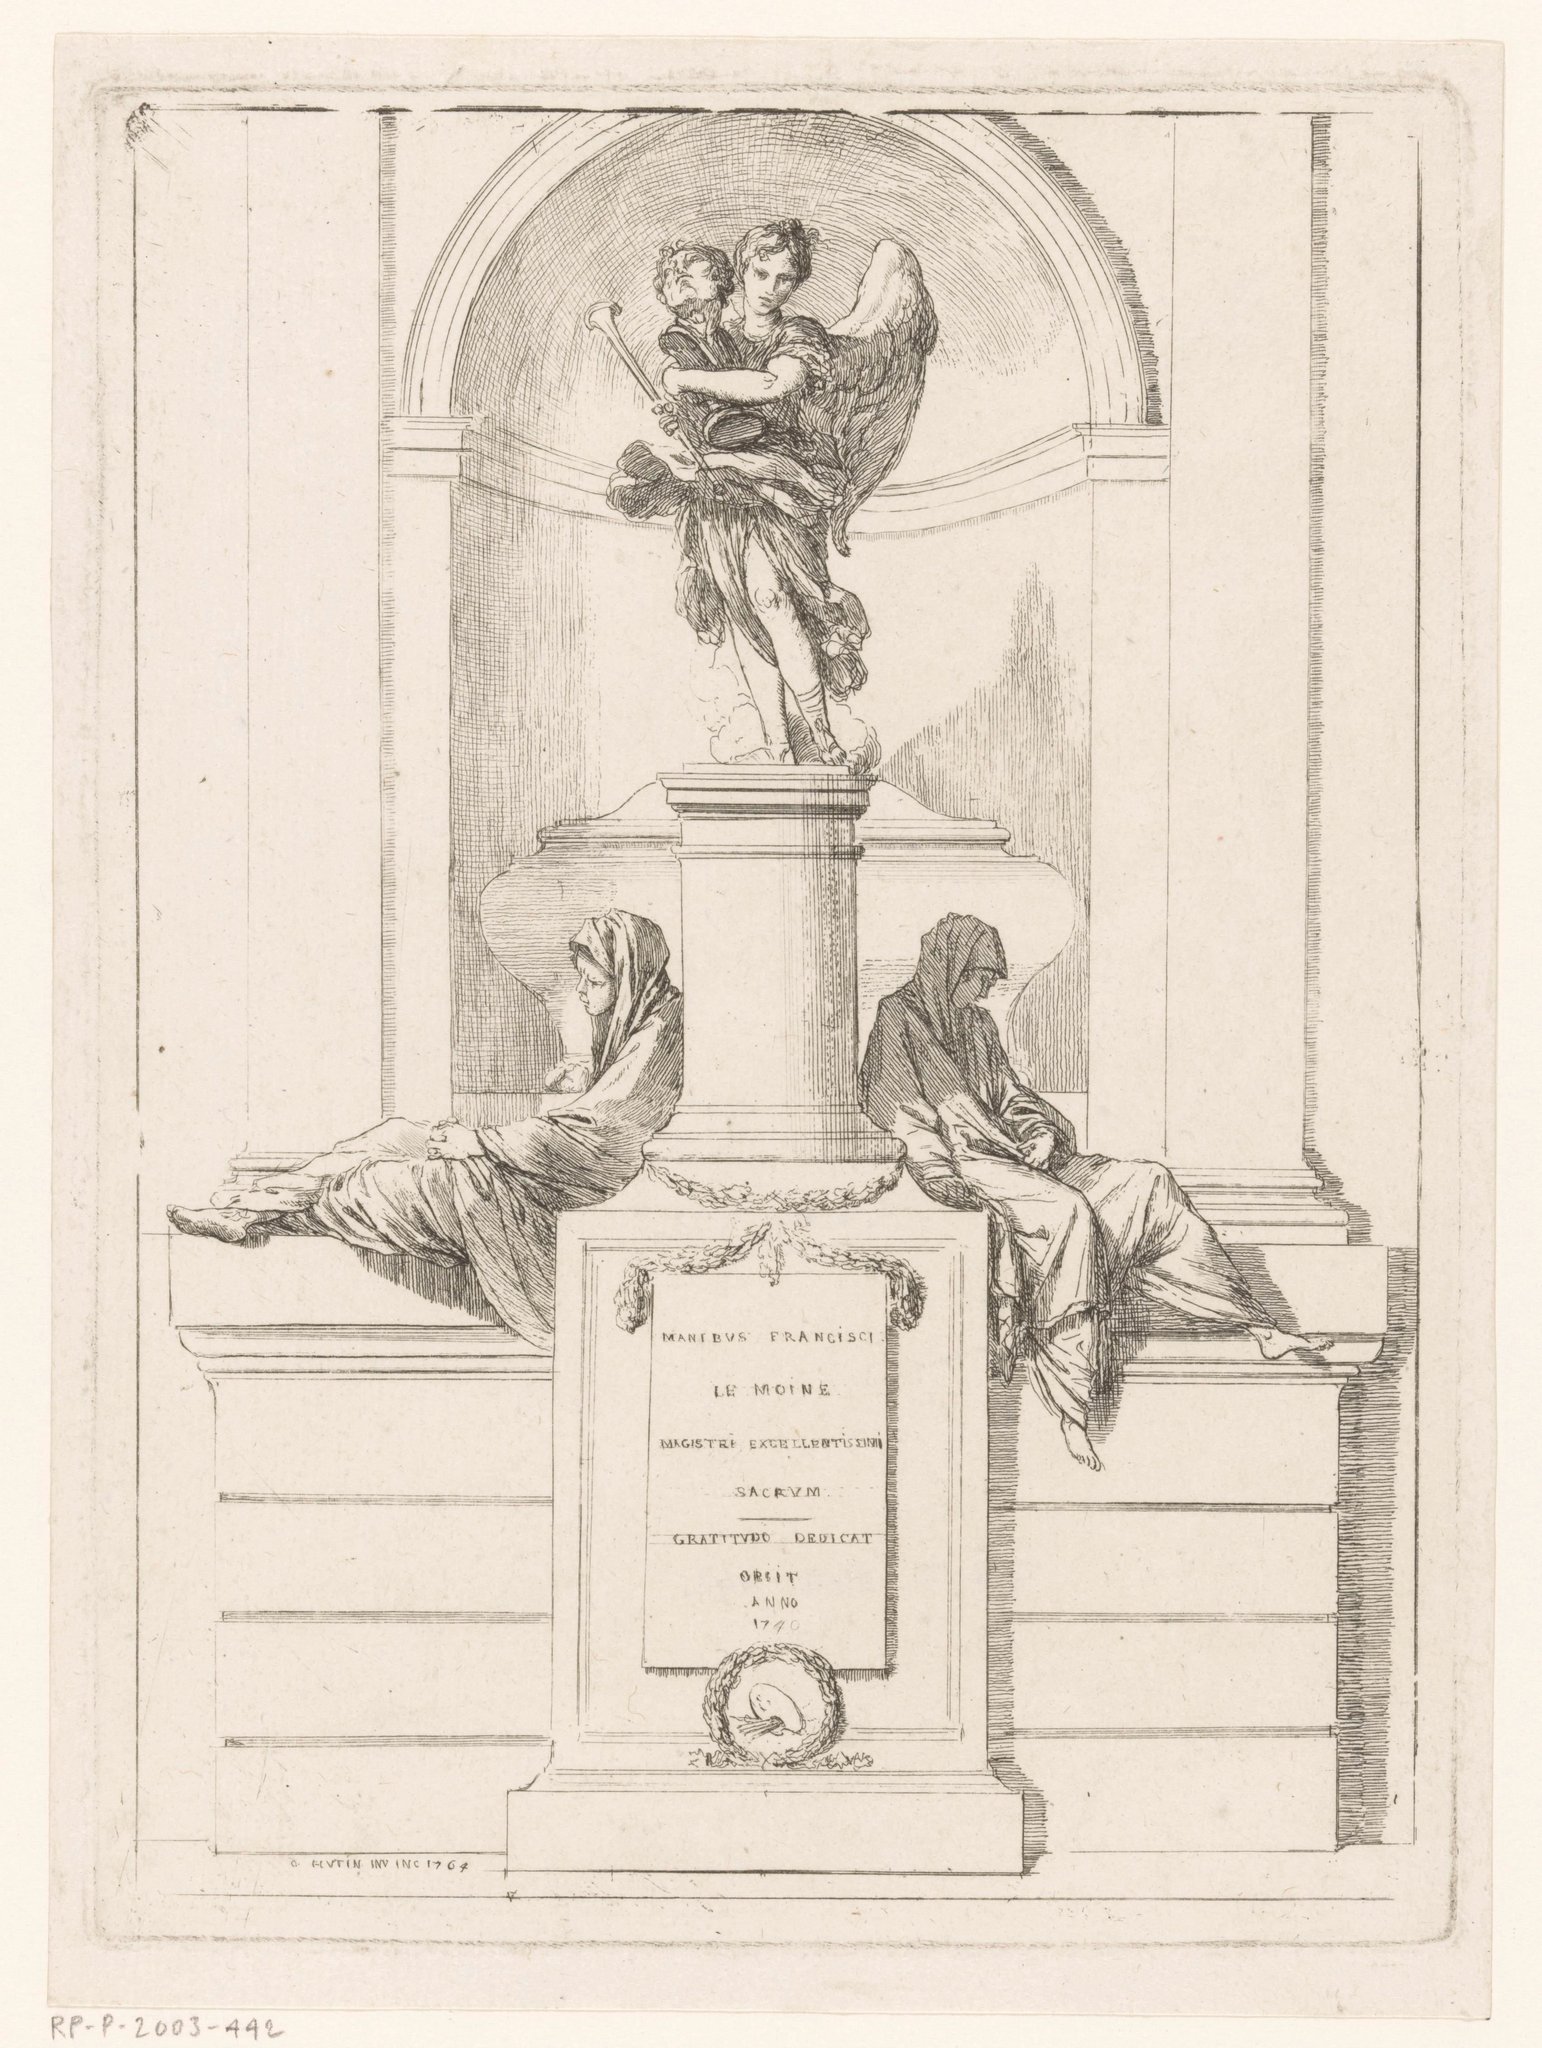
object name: print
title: Grafmonumenten voor kunstenaars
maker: charles françois hutin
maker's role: draughtsman, print maker, sculptor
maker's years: 1715-1776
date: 1764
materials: paper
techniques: etching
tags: grave, tomb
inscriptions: collector's mark: Lugt 2228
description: Grafmonument voor de kunstenaar Francois Lemoine. Zijn naam staat op de grafsteen, waarop een zuil een engel met bazuin en een buste van de kunstenaar. Aan weerszijden van de zuil een zittende vrouwenfiguur.